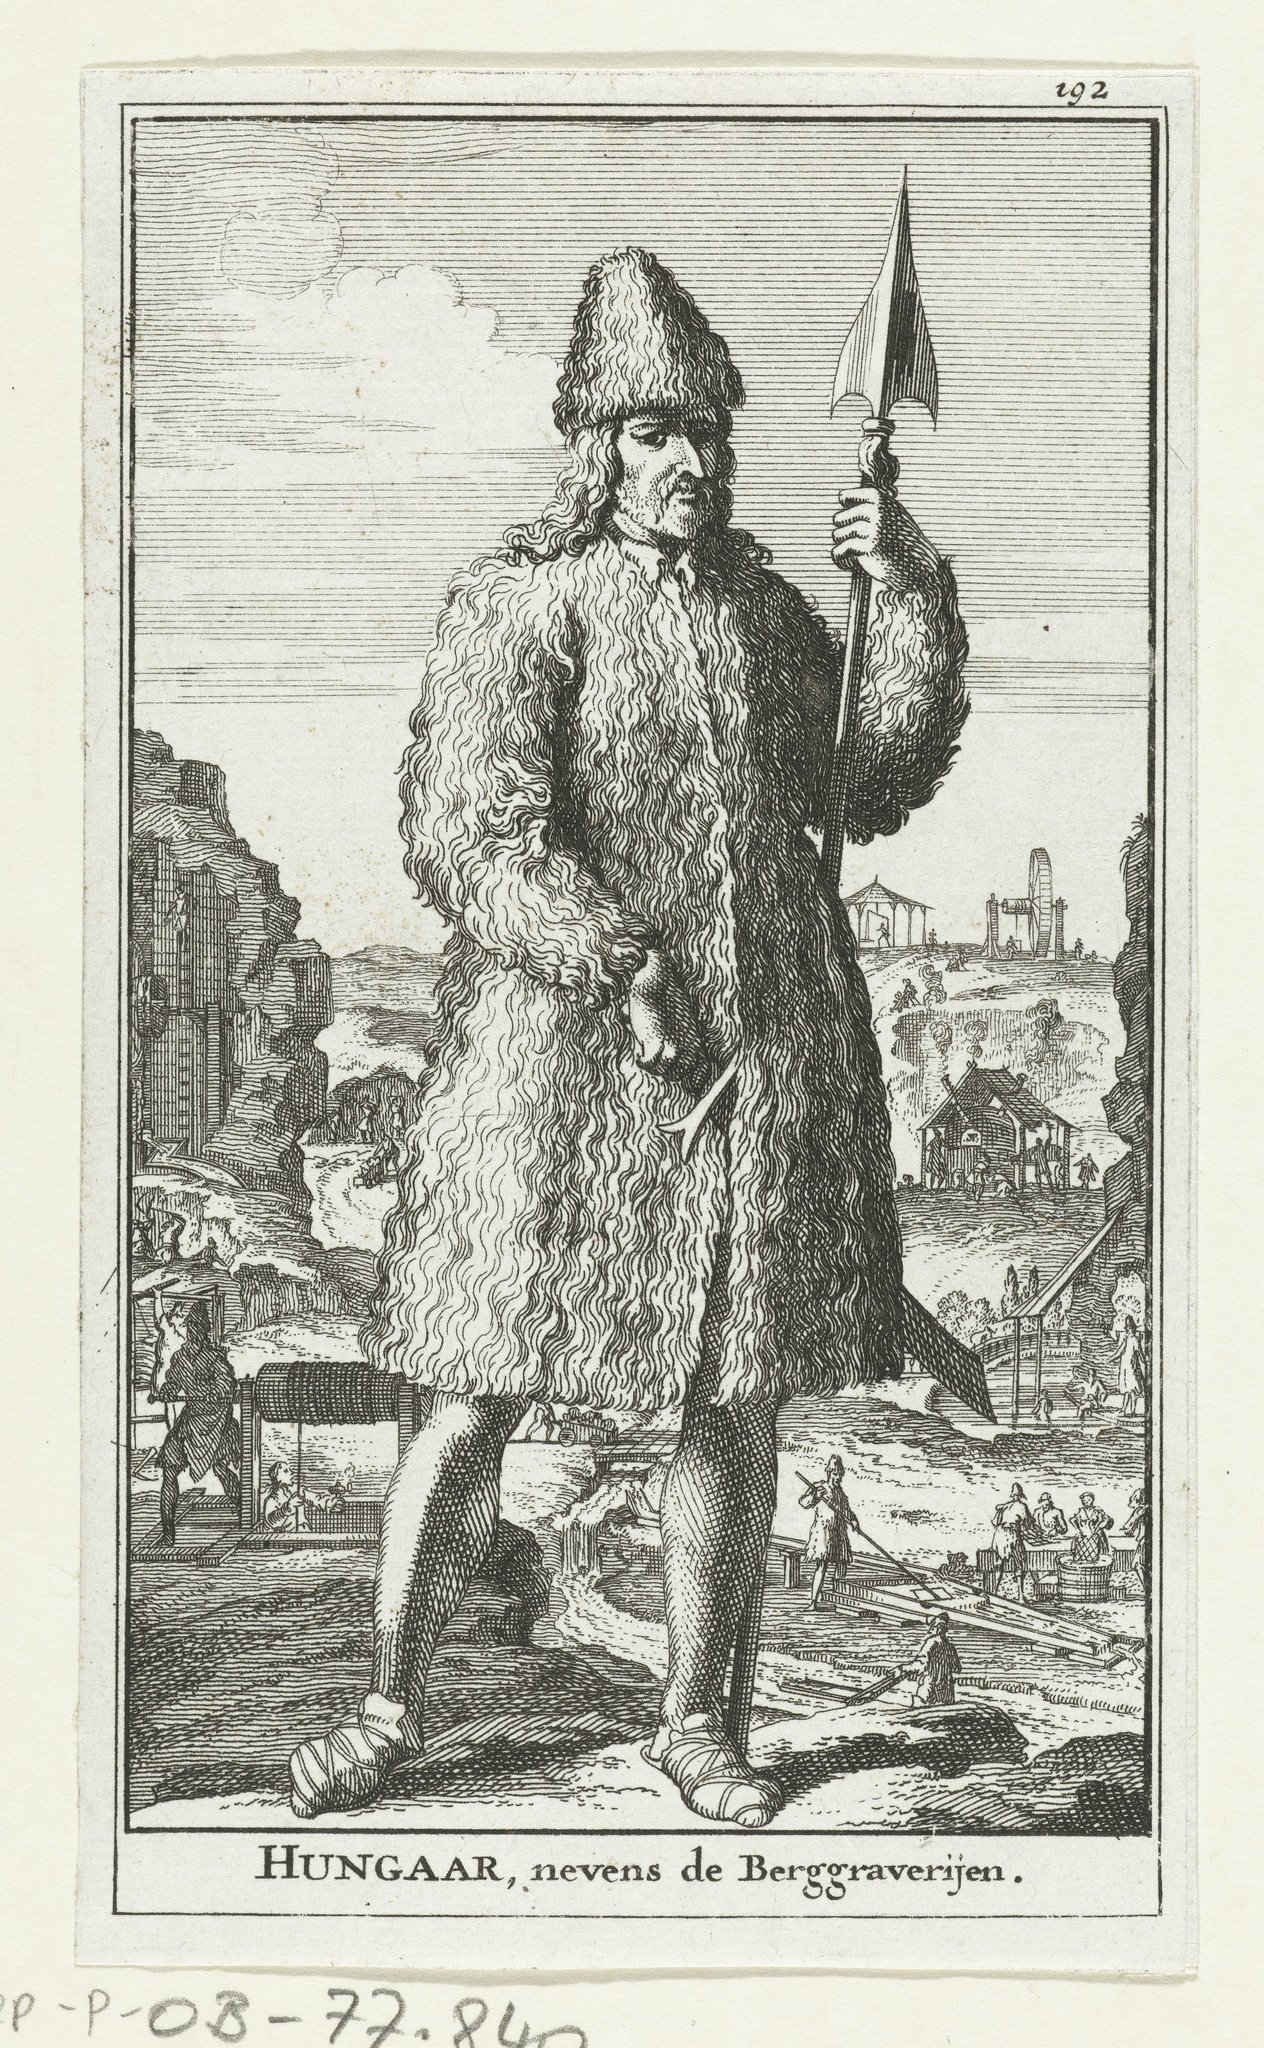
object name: print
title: Hongaar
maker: Anonymous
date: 1712-1714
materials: paper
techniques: etching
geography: netherlands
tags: extinct, 'historical' peoples (with name), netherlands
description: Gebruikt als illustratie in: Hugo de Groots Antiquitates Germanicæ, of Hoogduitsche oudtheden: waar in de gelegentheid en zeeden der Germaanen, beschreeven door Tacitus, naaukeurig verklaart, en met printverbeeldingen opgeheldert worden: benevens H. Grotius verhandeling van de oudtheid der Batavische republyk. Amsterdam: Jacob van Royen, 1714.